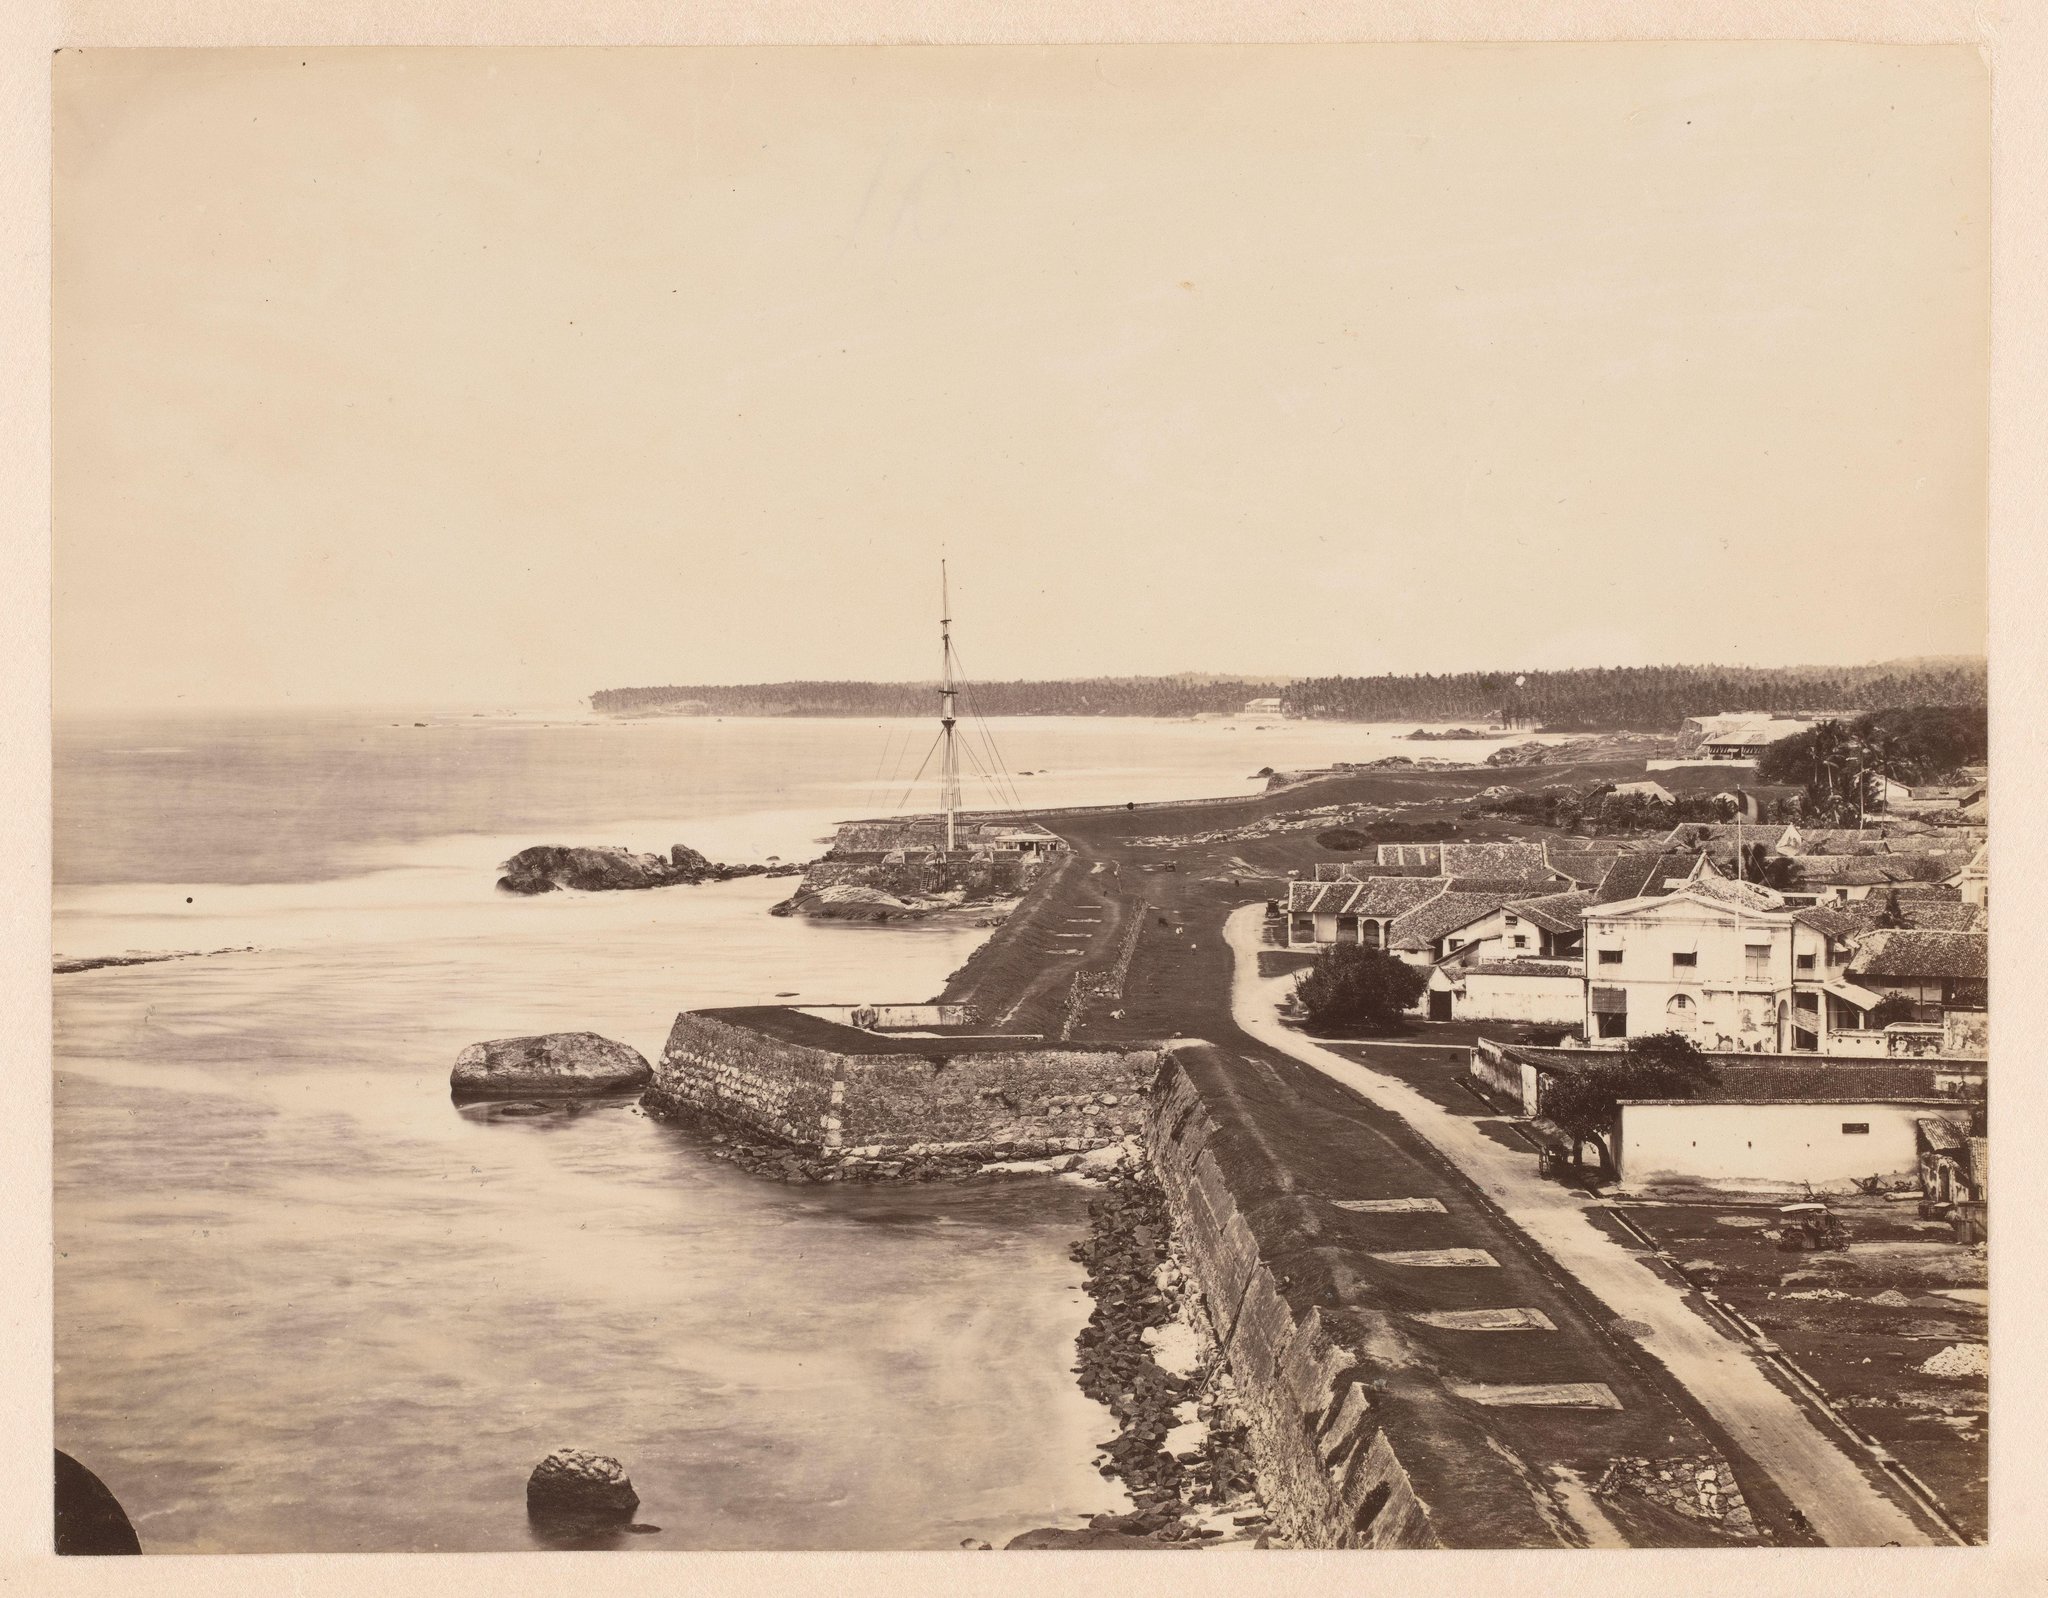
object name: photograph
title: Haven met vestingwerken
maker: Anonymous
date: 1865-1870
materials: paper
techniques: albumen print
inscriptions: number: ‘BD.162’, number: ‘16’